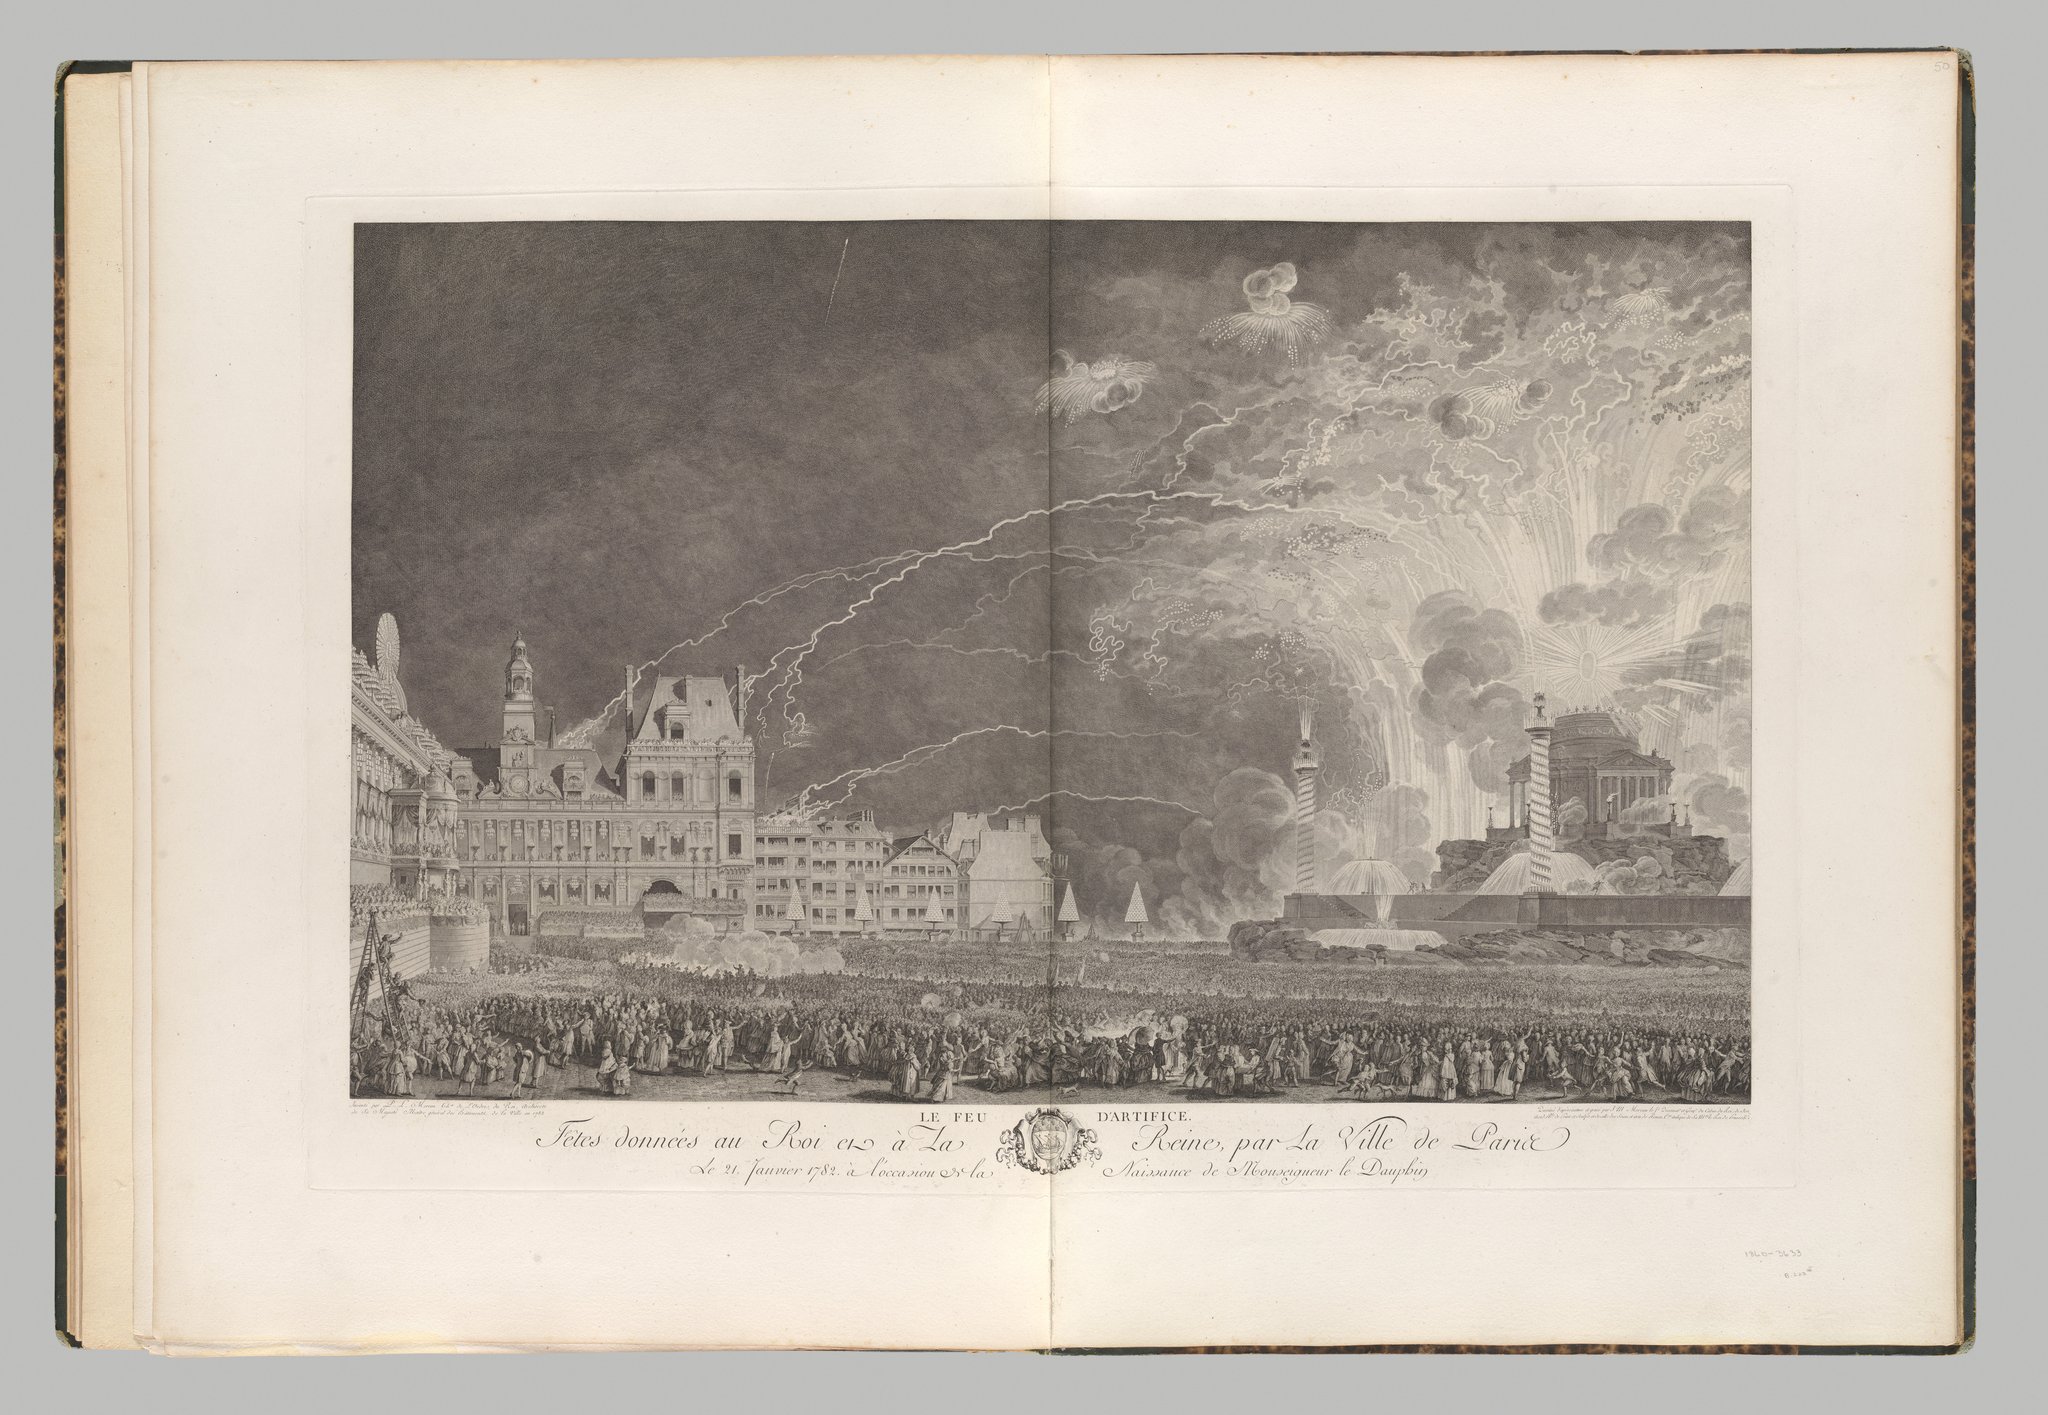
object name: print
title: Birth of the Dauphin: The Crowd Watching the Fireworks on the Place de la Grève, Paris, January 21, 1782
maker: jean michel moreau le jeune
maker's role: artist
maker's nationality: french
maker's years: 1741-1814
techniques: engraving, etching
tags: fireworks